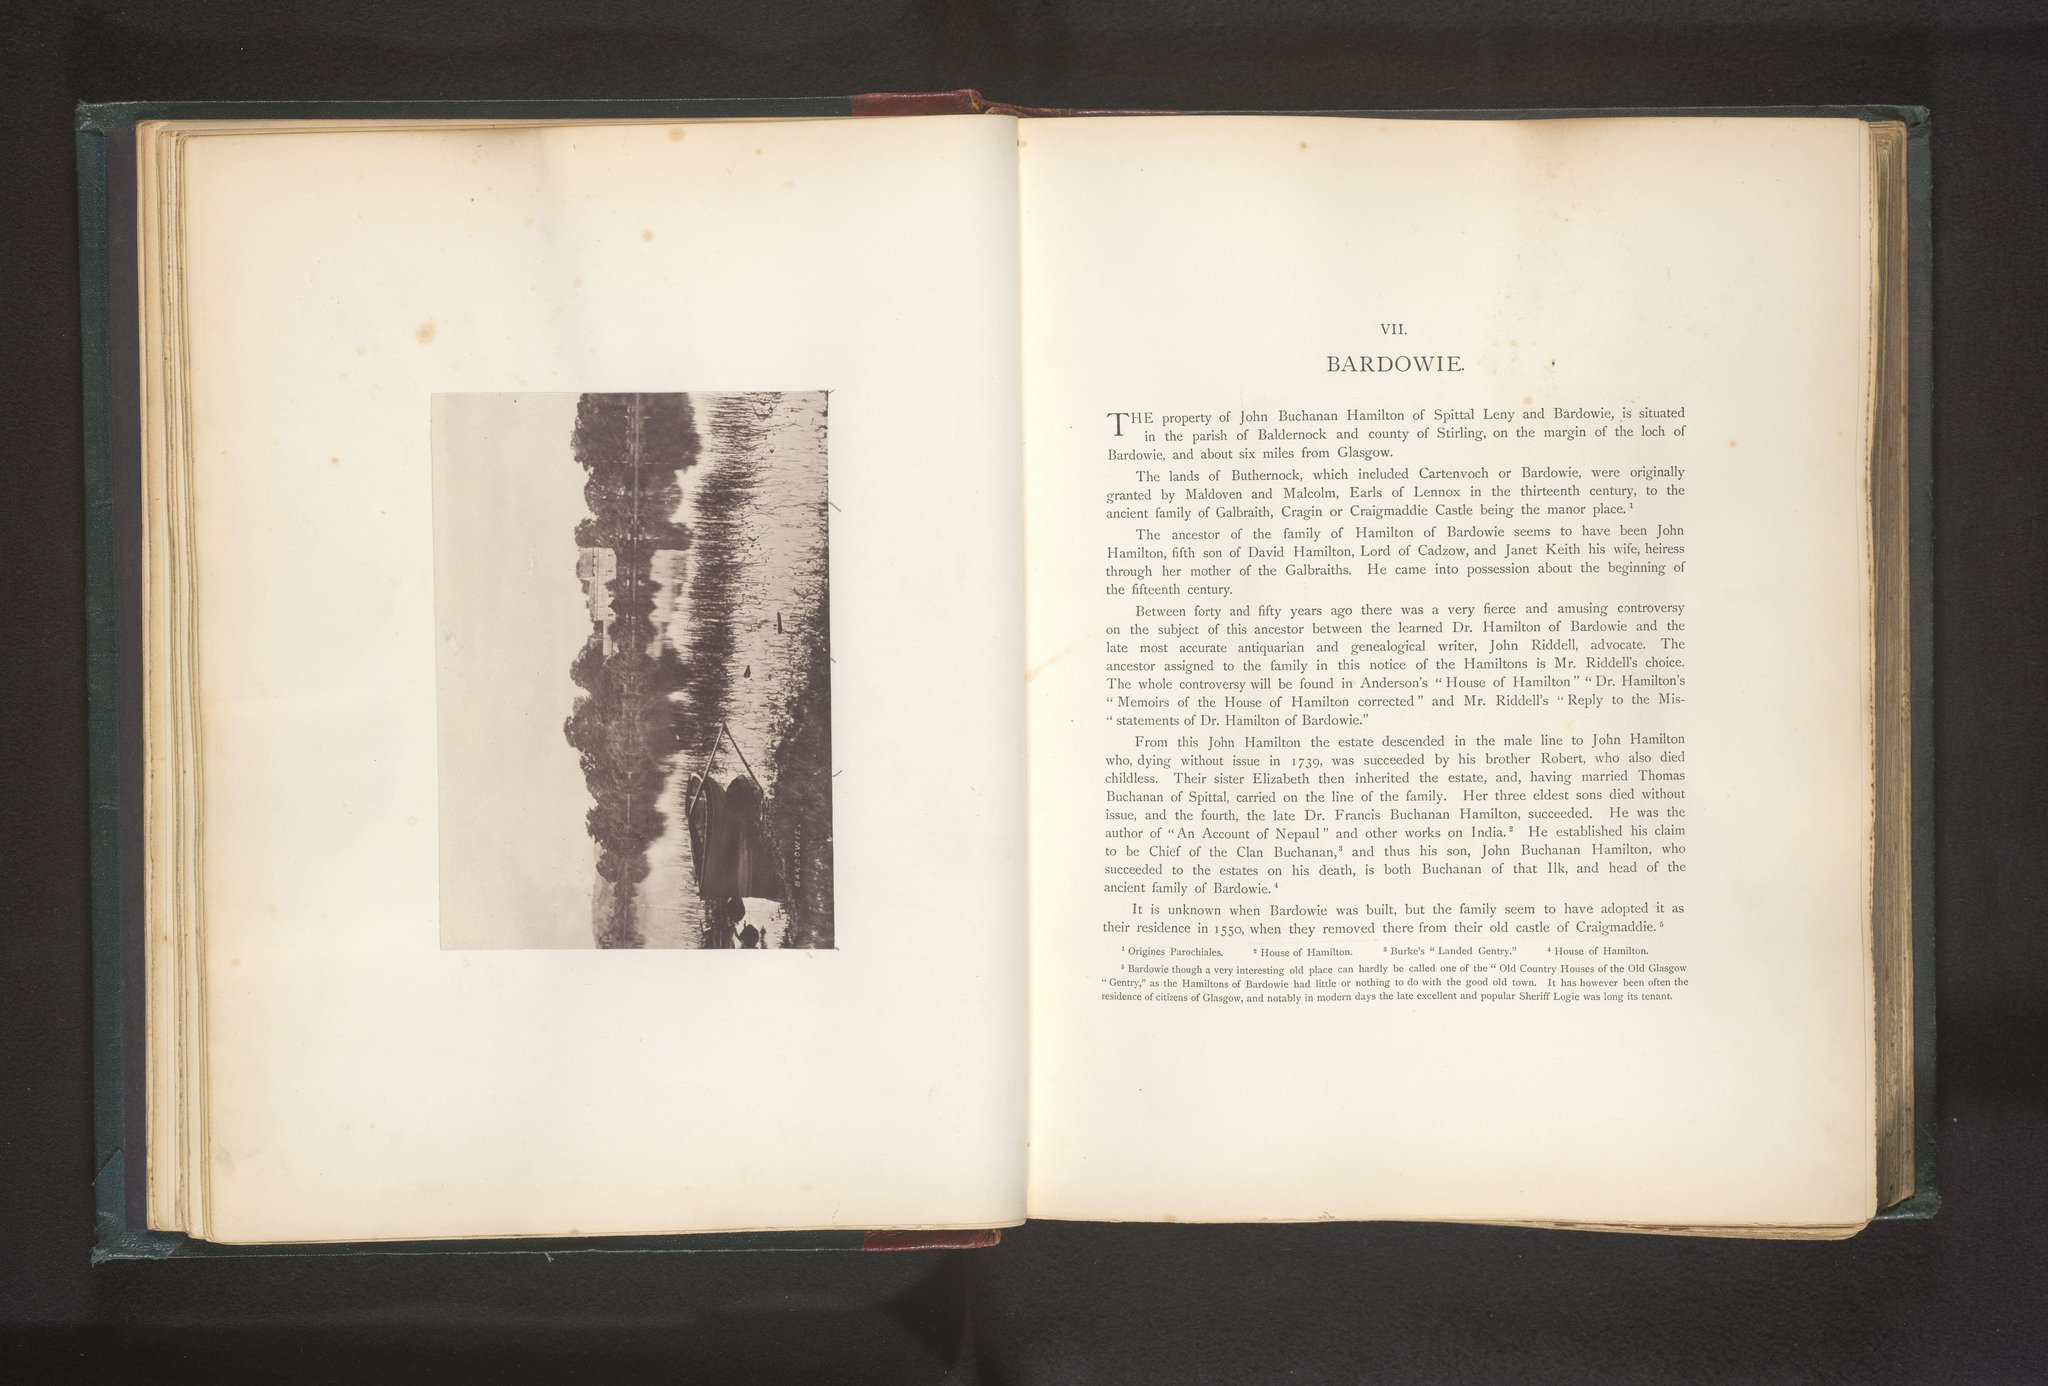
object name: photograph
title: Bardowie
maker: thomas annan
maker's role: fotograaf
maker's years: 1829-1887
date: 1868-1878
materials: paper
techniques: carbon print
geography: east dunbartonshire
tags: castle, façade (of house or building)